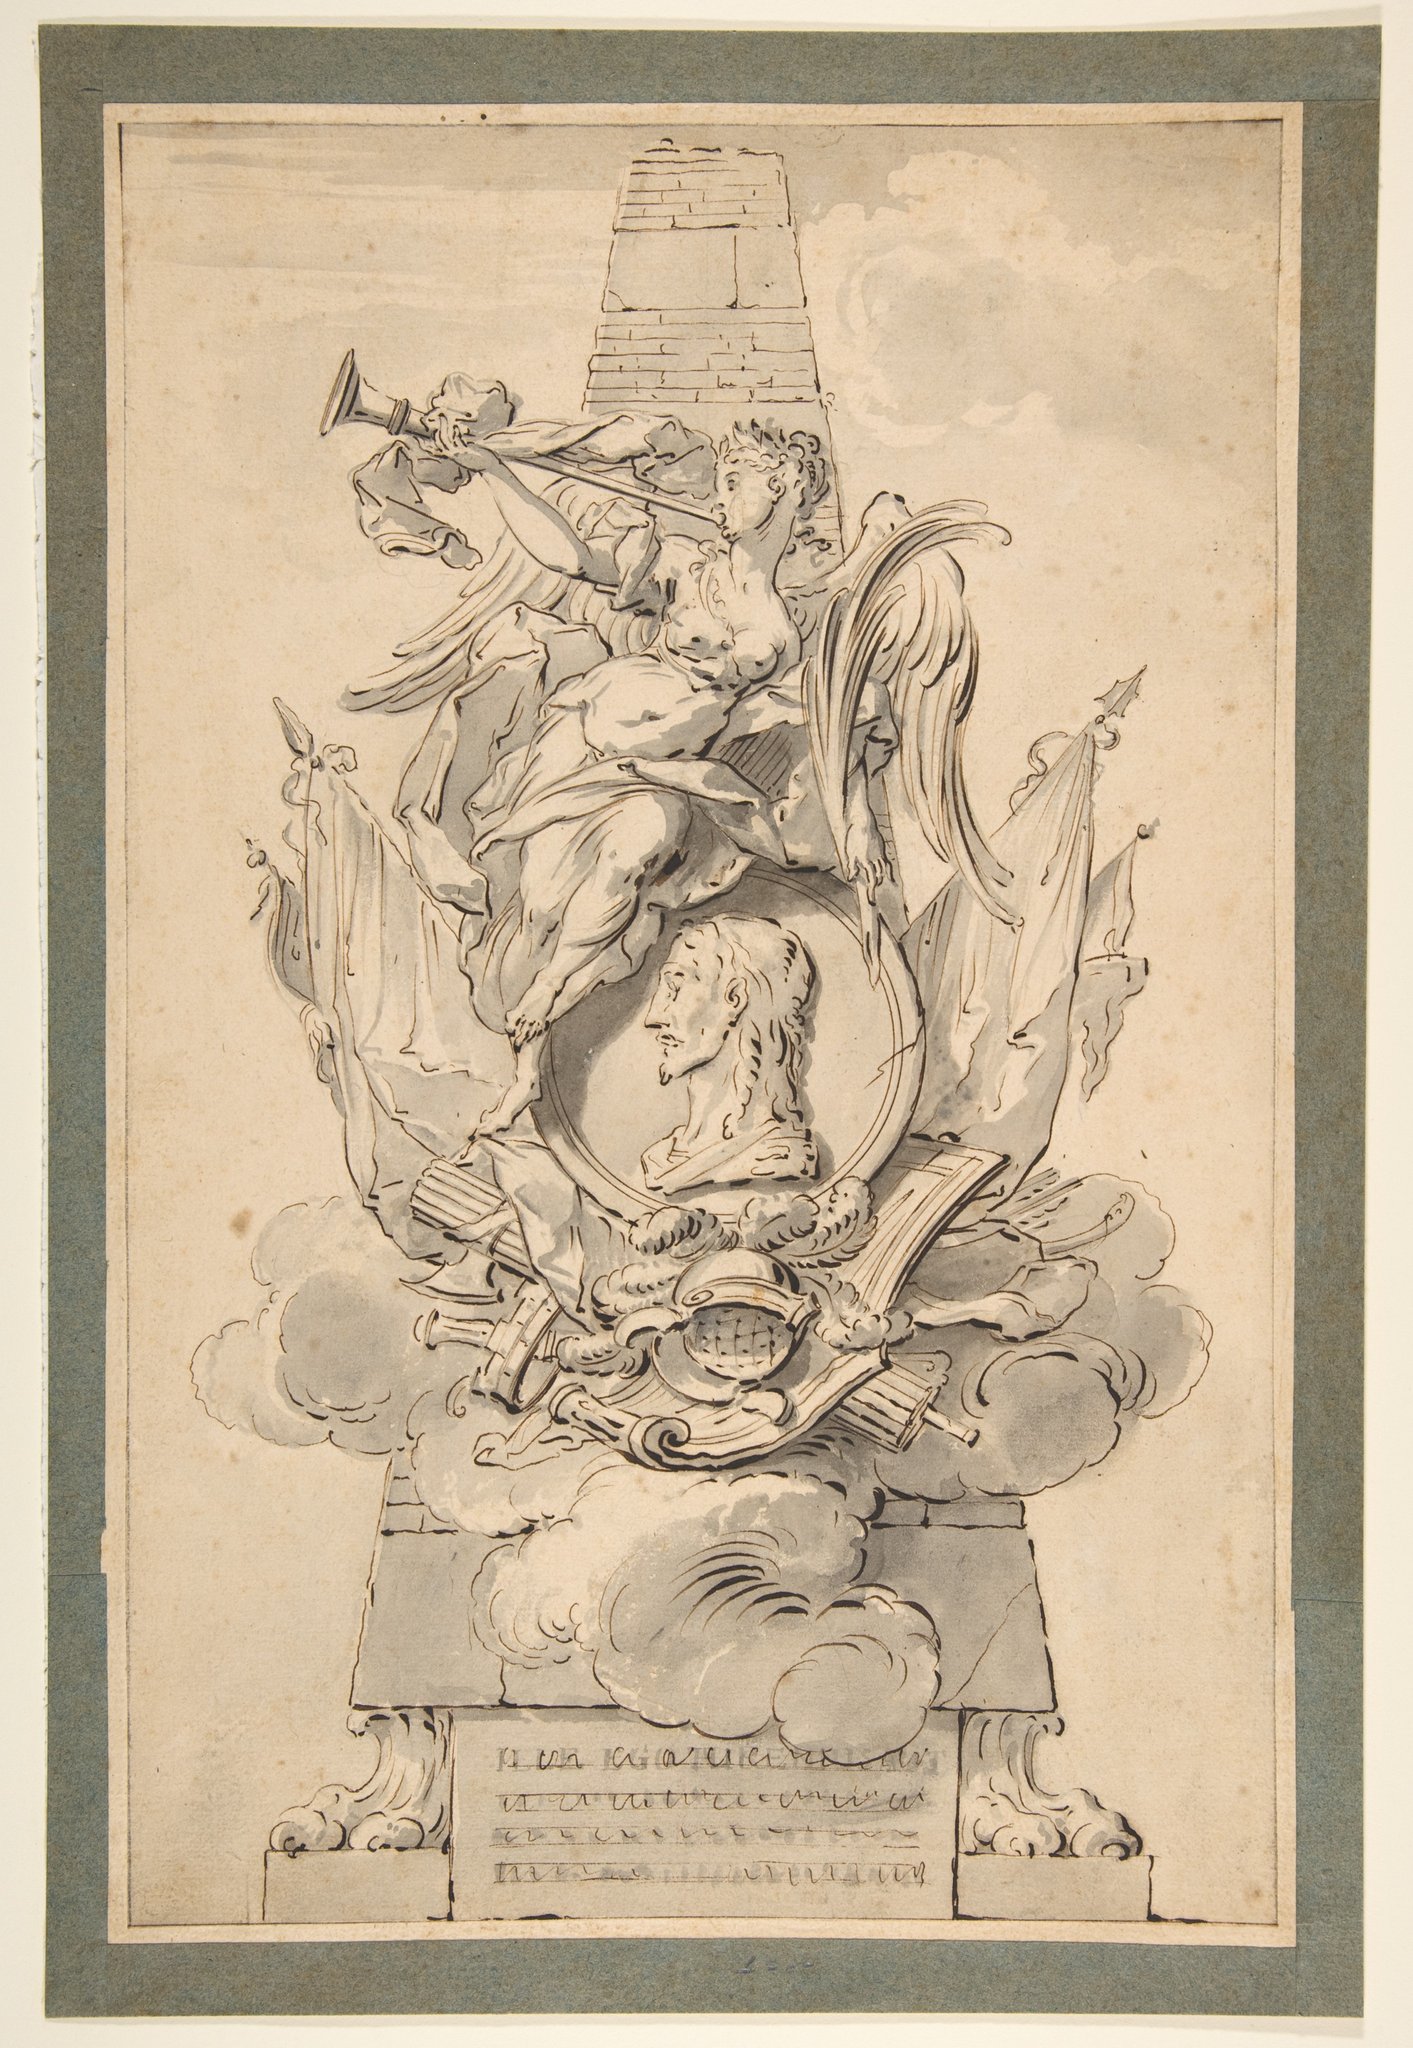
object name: drawing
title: Design for a Monument to a Military Leader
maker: gilles-marie oppenord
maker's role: artist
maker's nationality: french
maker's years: 1672-1742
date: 1690-1740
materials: ink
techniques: brush, pen, wash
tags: musical instruments,monuments,men,profiles